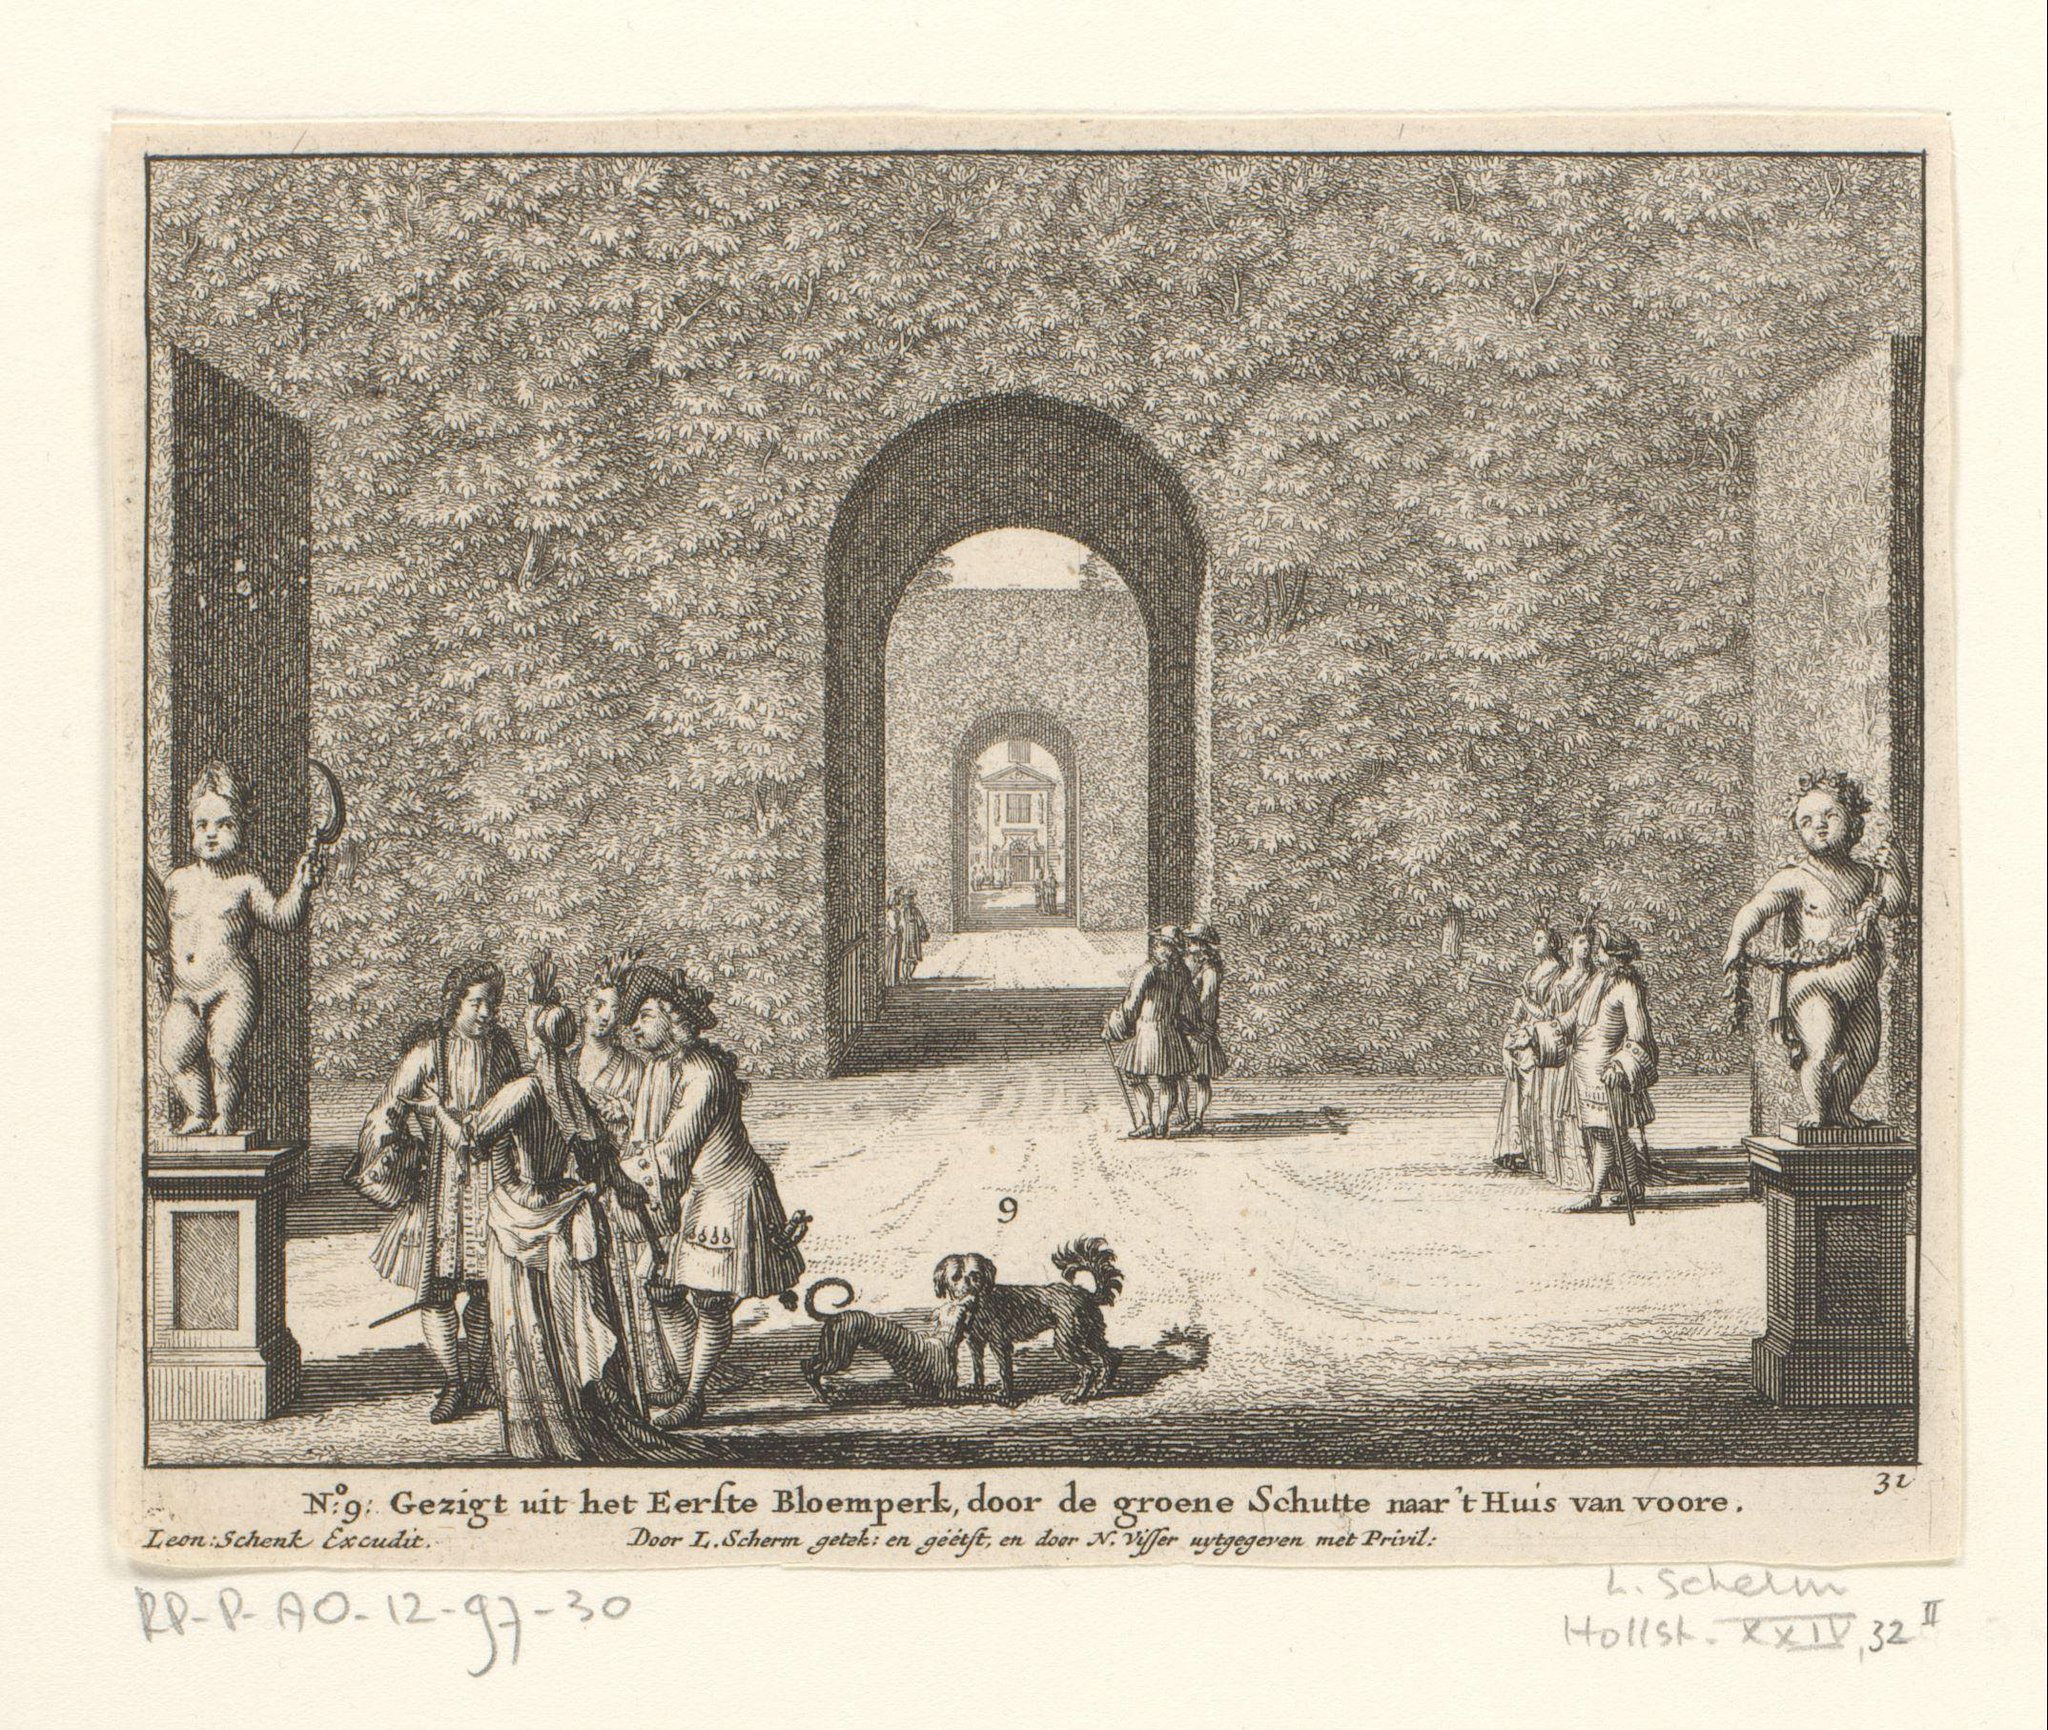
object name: print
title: Gezicht op hoge hagen en het huis op het landgoed Clingendael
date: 1682-1726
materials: paper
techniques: etching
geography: amsterdam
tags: french or architectonic garden; formal garden, statues, sculptures in garden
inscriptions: collector's mark: Lugt 2228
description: Gezicht op vanuit het eerste bloemperk op hoge hagen en het huis op het landgoed Clingendael te Den Haag.